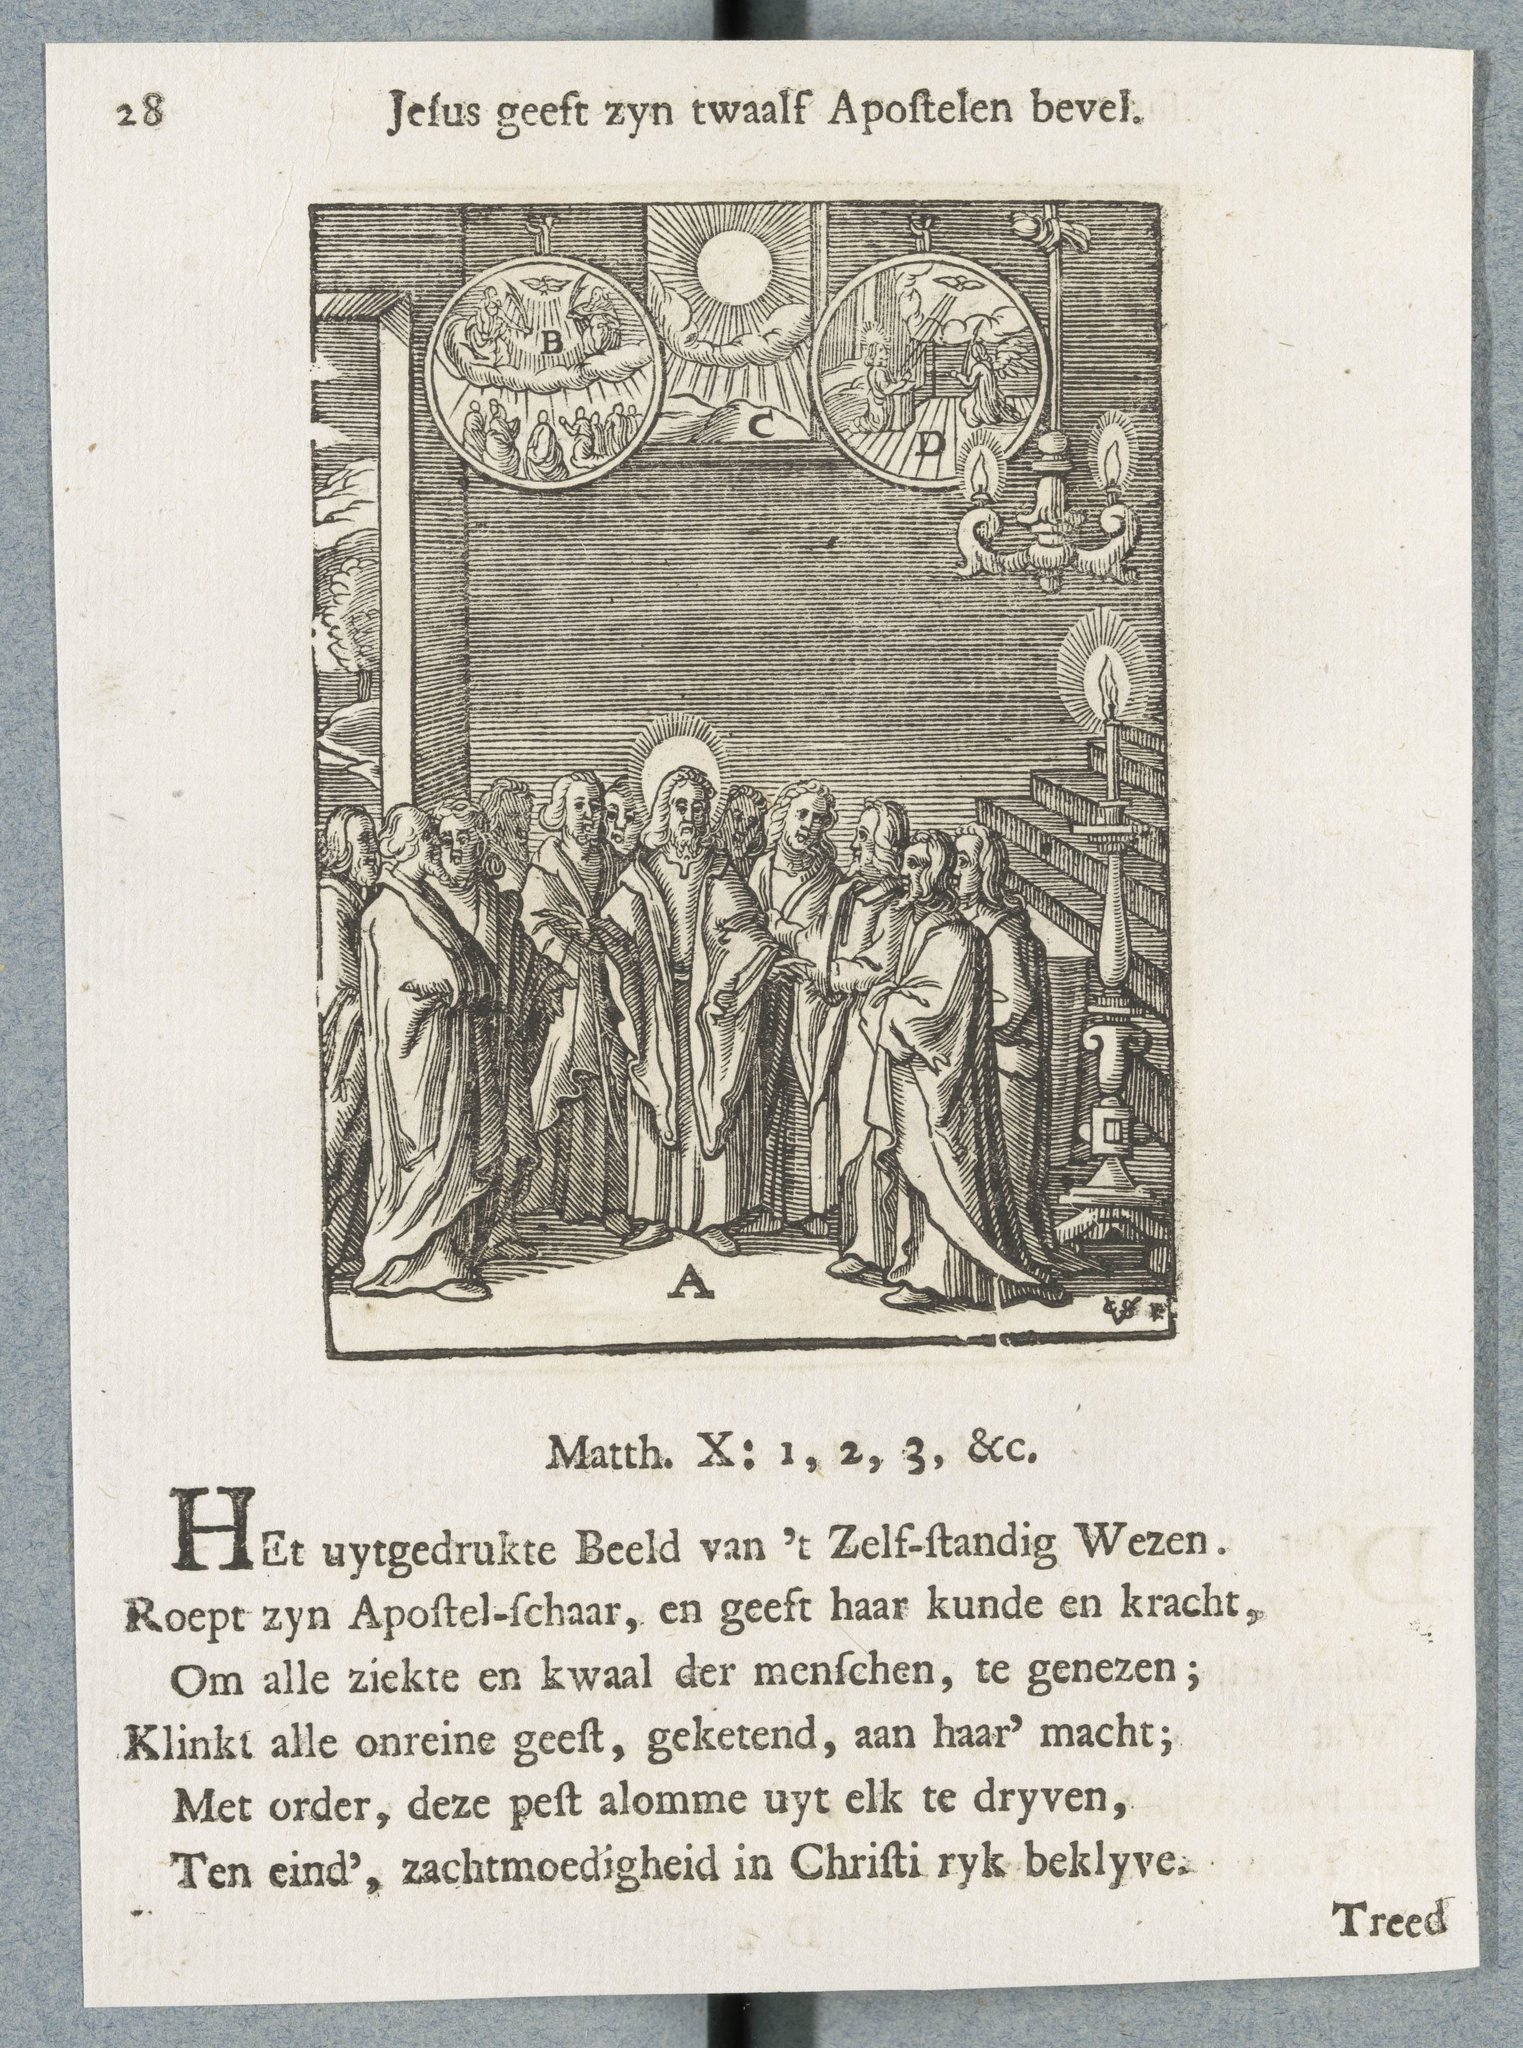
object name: album leaf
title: Christus predikt over het gebed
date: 1629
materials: paper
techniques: letterpress printing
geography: antwerp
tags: christ's conditions for prayer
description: De prent is afkomstig uit: Bybels Lusthof. Amsterdam, J. Klooster, 1740. De prent werd gemaakt voor de uitgaven van P.J. Paets uit Amsterdam, verschenen in de jaren 1629-1648. Ze komt voor het eerst voor in: Der Zielen Lust-hof. Leuven, I.Jacbosz voor P.J. Paets [= Amsterdam, P.J. Paets], 1629. De voorstelling is gekopieerd naar een prent van Antonie II Wierix voor: Nadal, Jerónimo. Evangelicae Historiae Imagines. Antwerpen, M. Nutius, 1593.